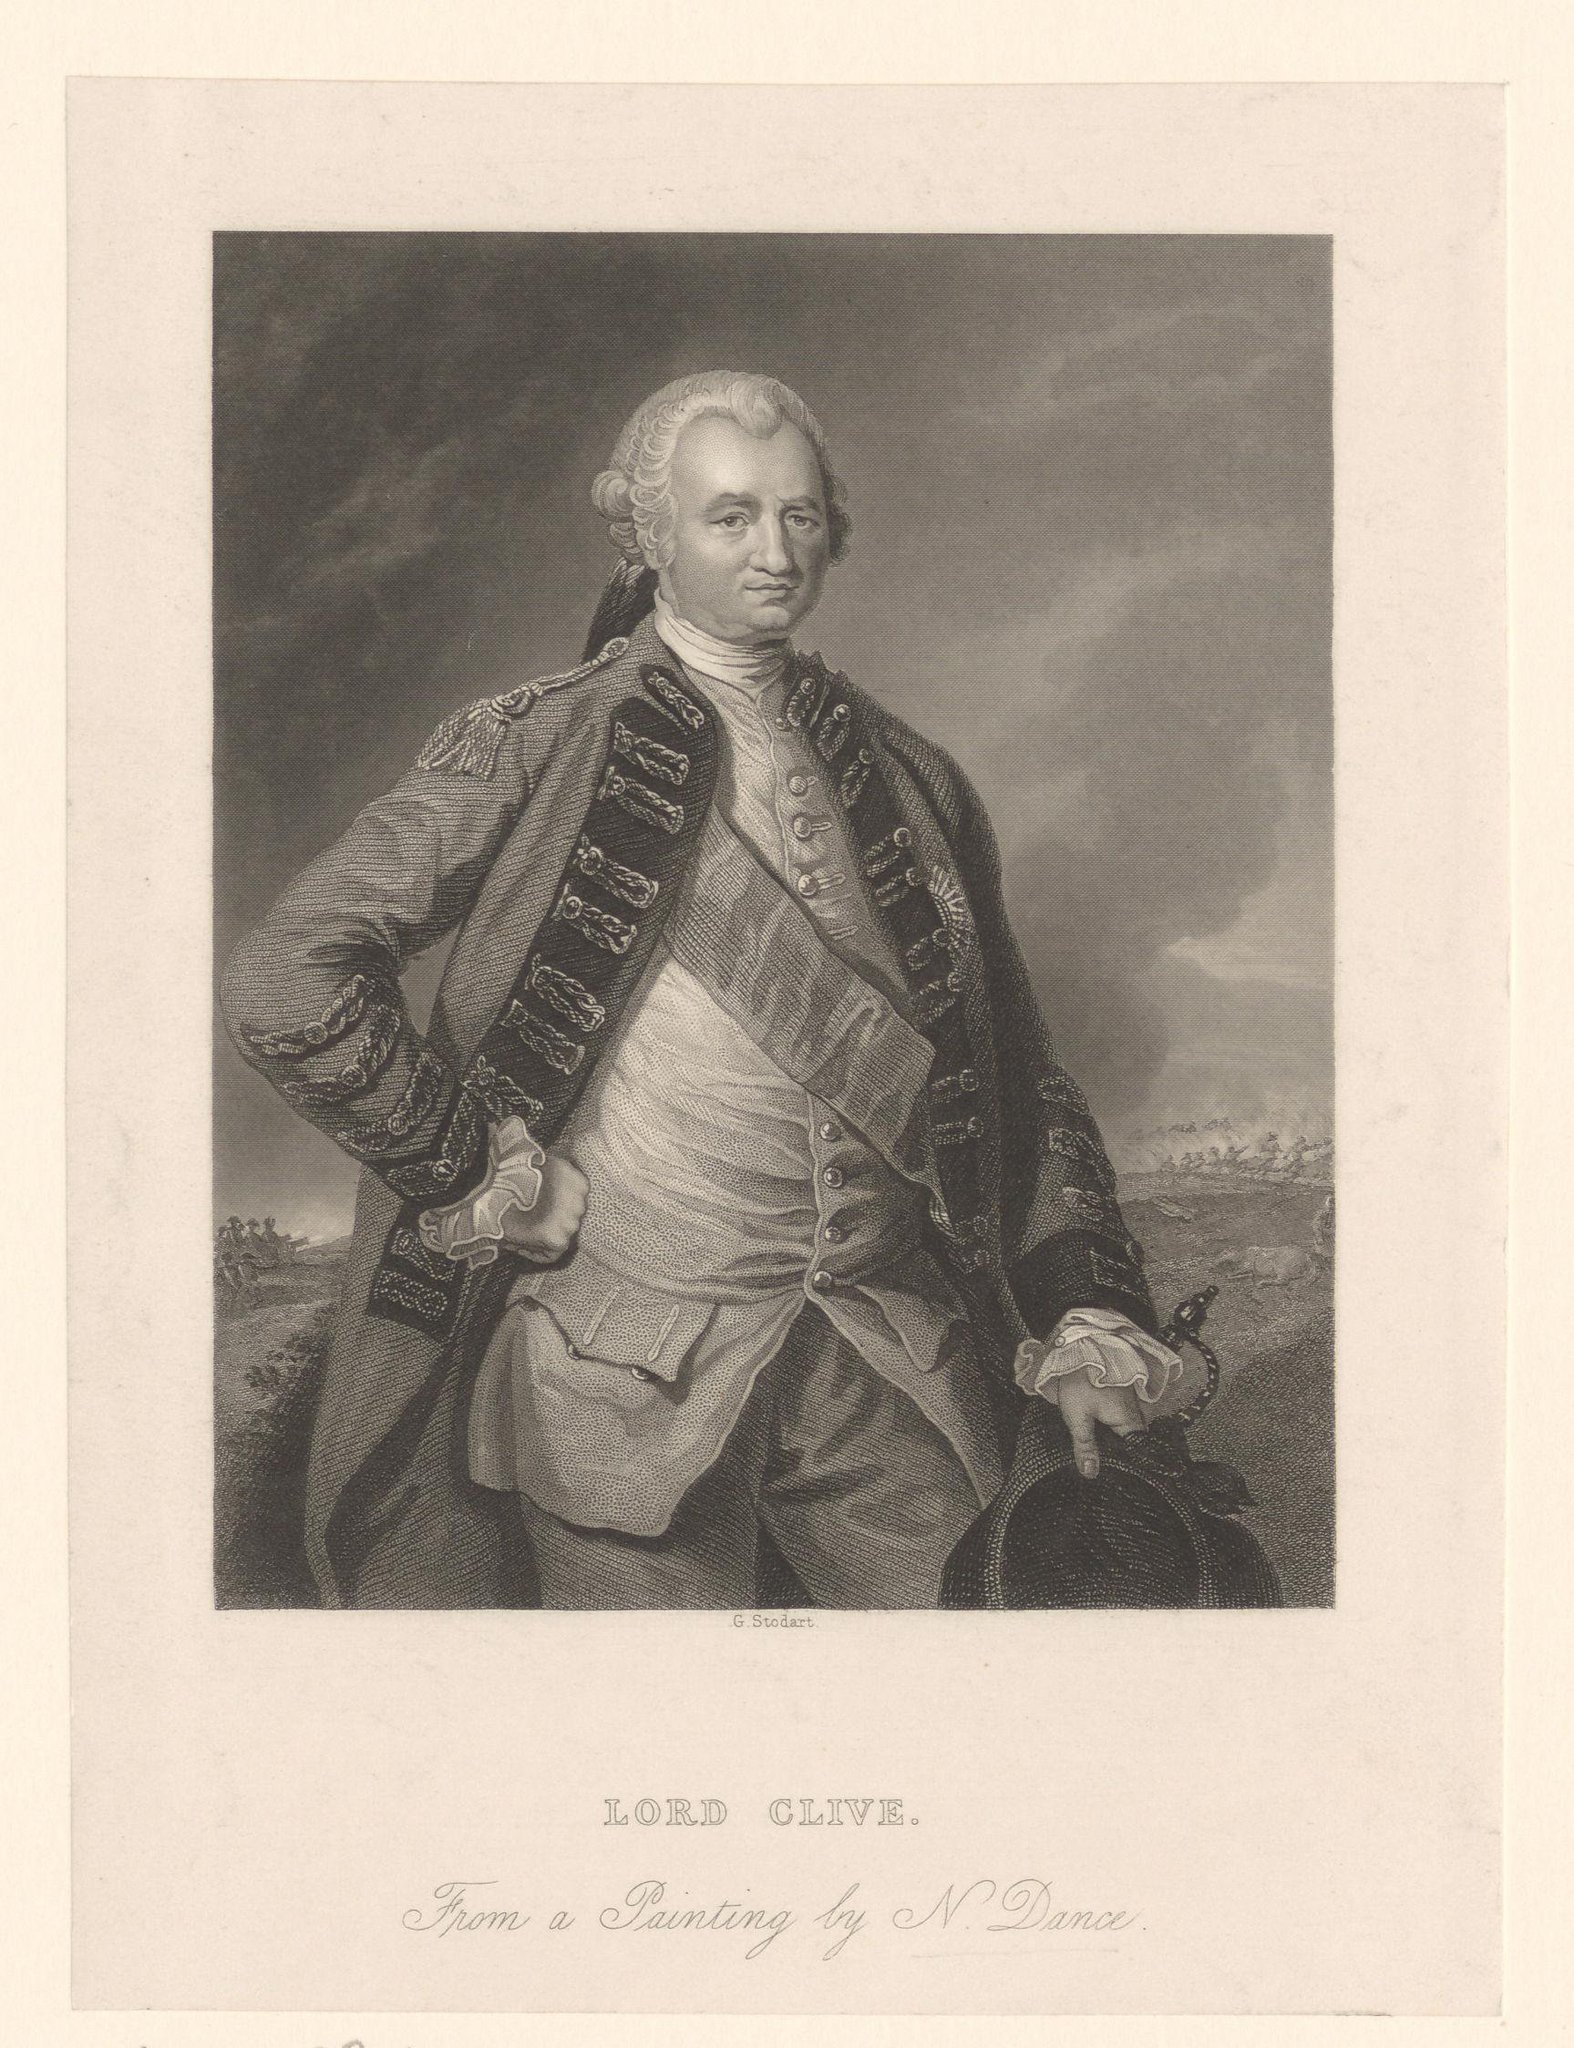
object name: print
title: Lord Clive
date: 1850-1886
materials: paper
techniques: etching, engraving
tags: politician, historical persons, officer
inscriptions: collector's mark: Lugt 2228